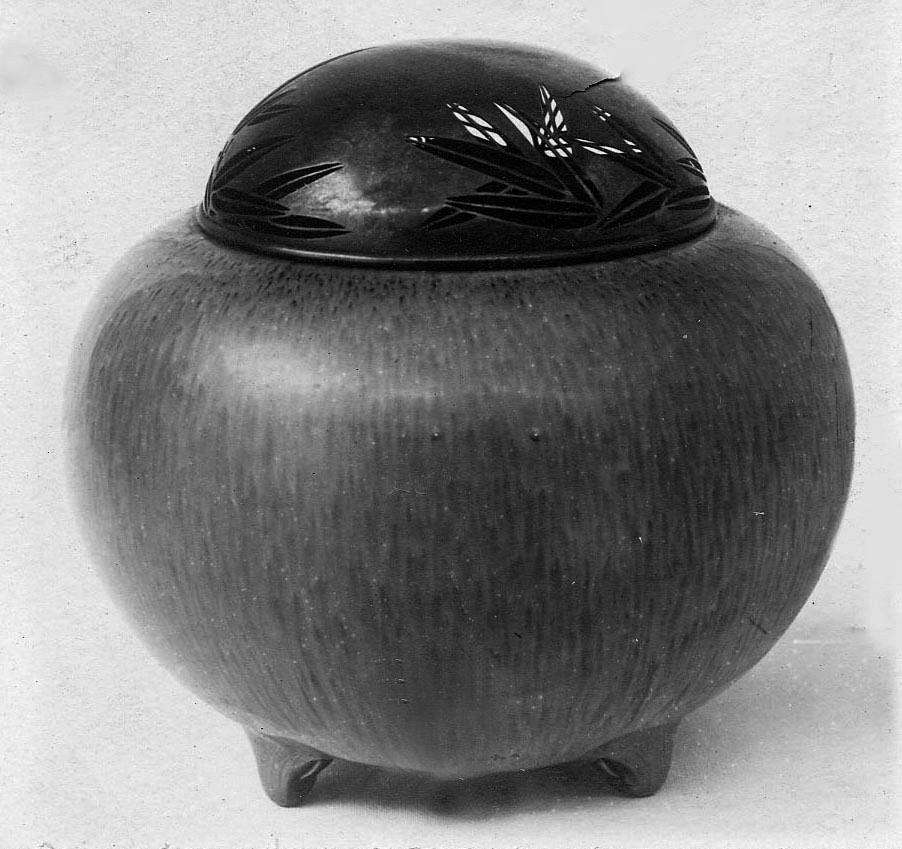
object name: censer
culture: japanese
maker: takemoto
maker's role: artist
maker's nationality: japanese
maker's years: 1845-1892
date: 1892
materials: glaze, porcelain